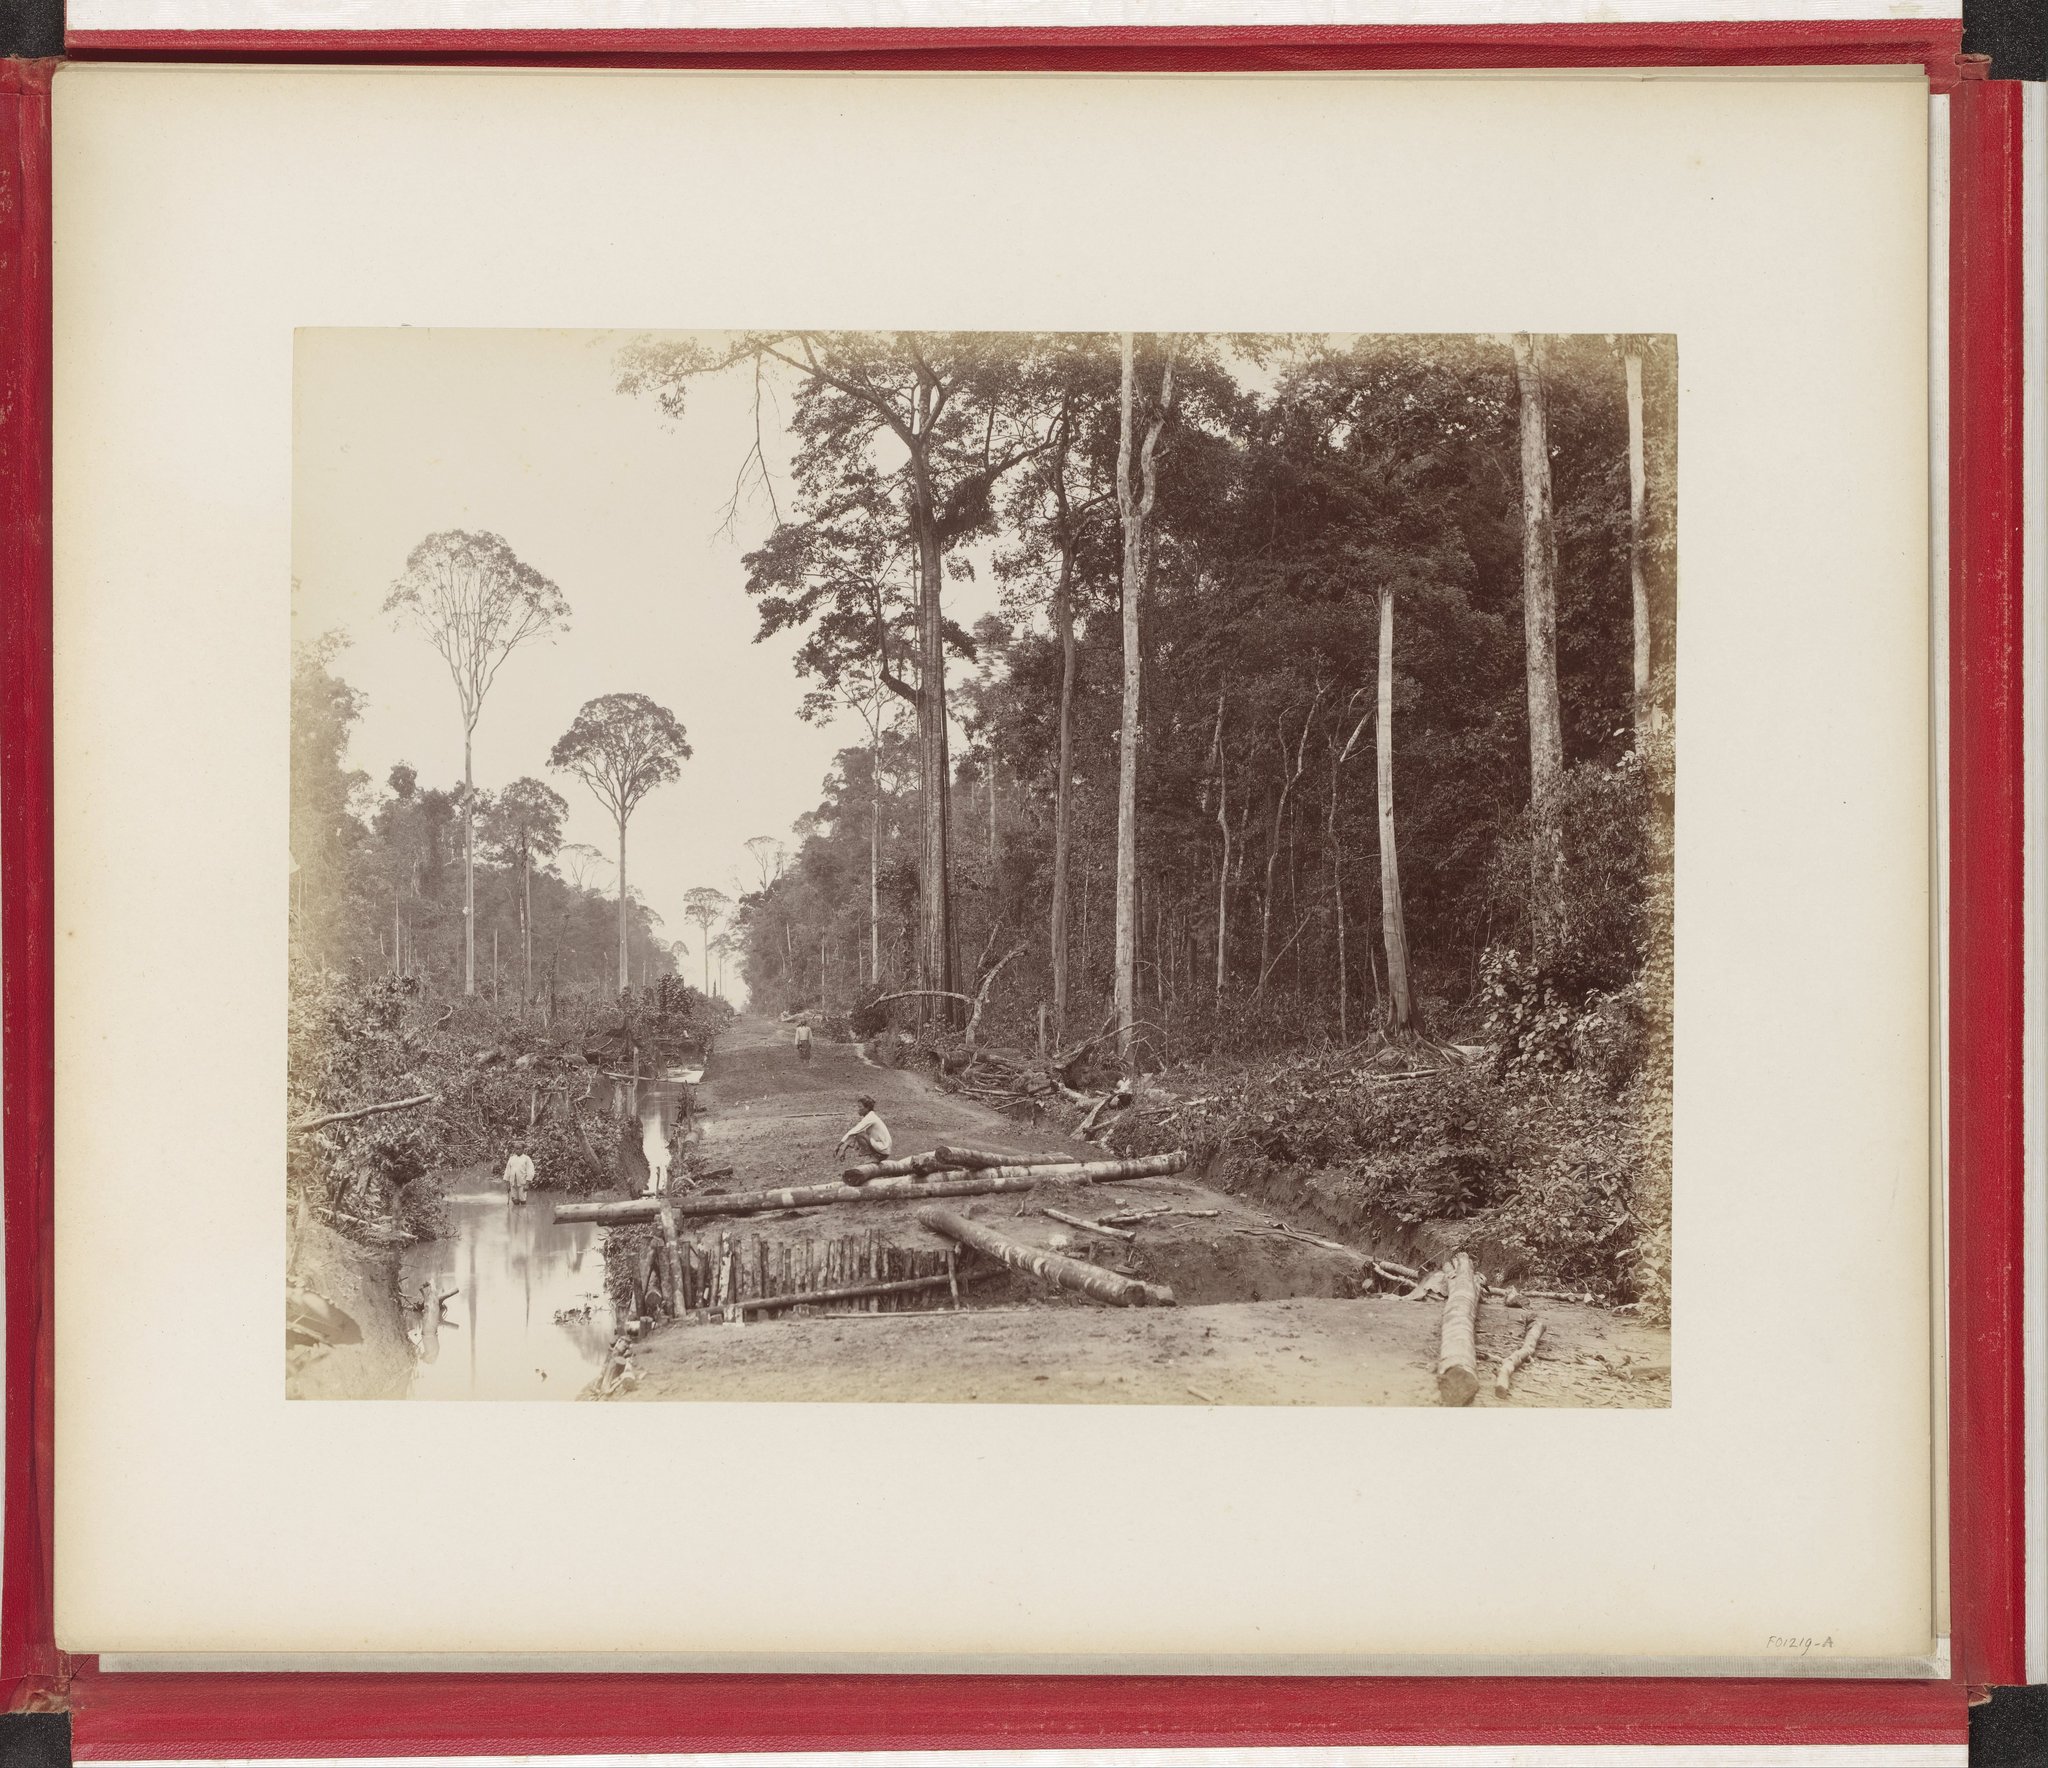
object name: photograph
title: Aanleg van een tabaksplantage op Sumatra, 1e stadium: rooien van bomen in een bos en wegaanleg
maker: Anonymous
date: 1880-1890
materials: cardboard, photographic support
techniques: albumen print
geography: east sumatra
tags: plantation, tobacco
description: Onderdeel van Fotoalbum van de aanleg van een tabaksveld op de oostkust van Sumatra.